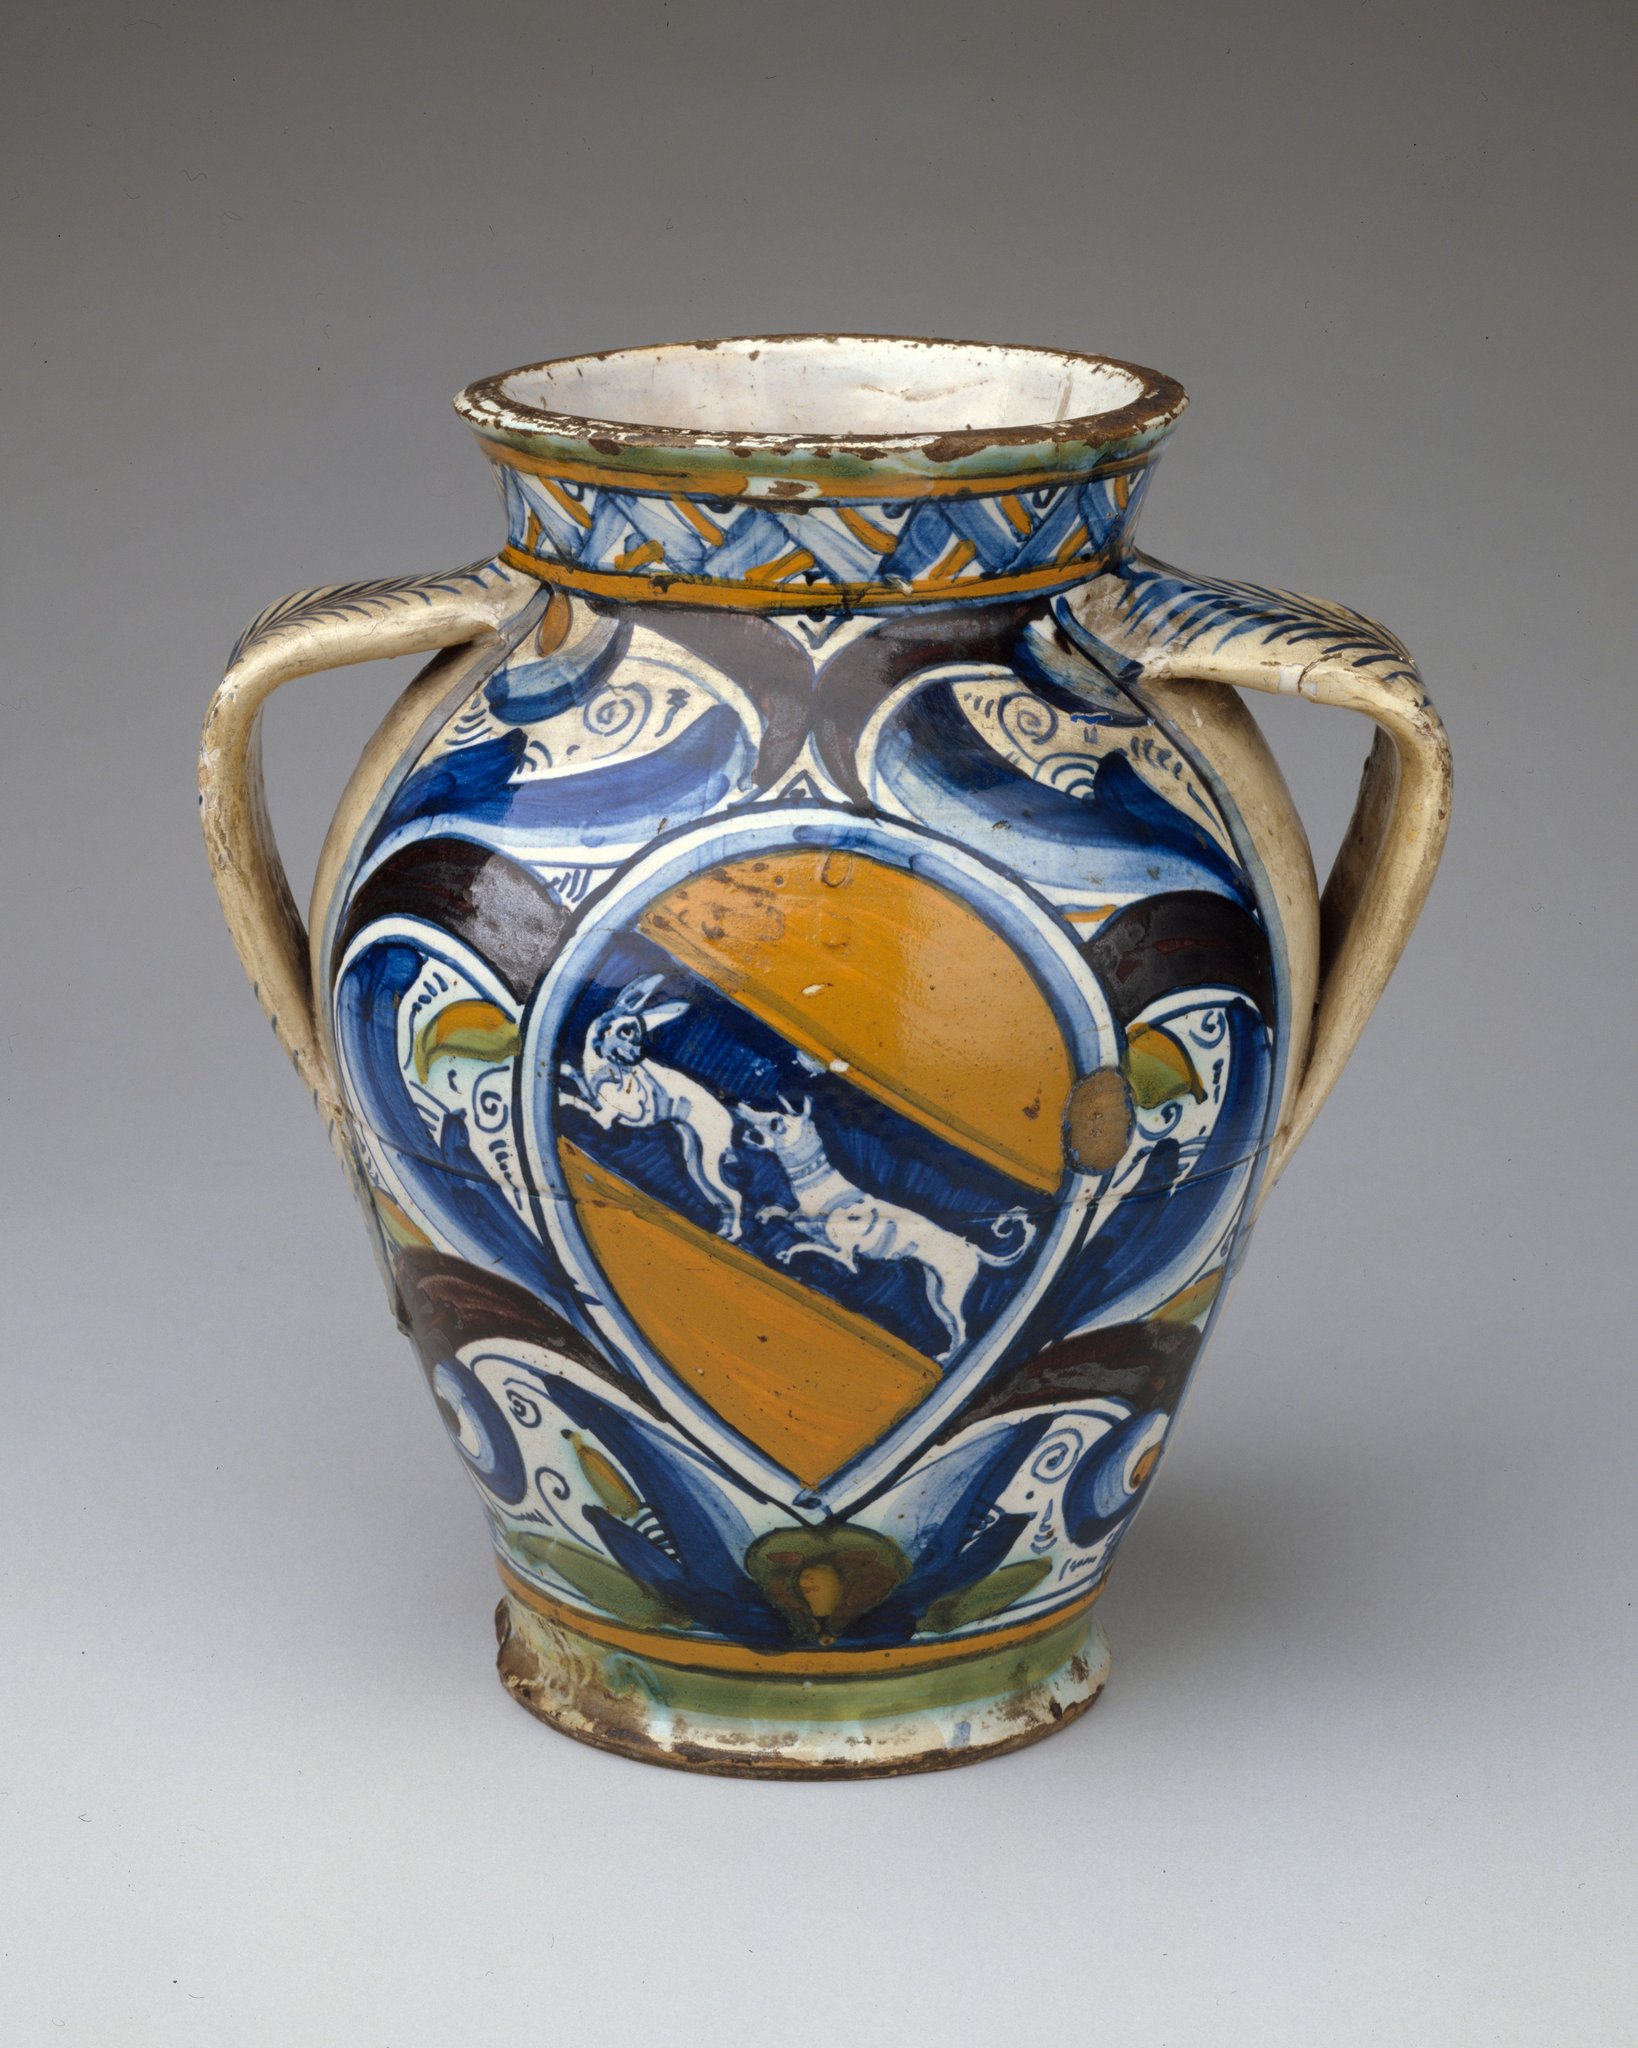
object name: apothecary jar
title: Apothecary Jar (orciuolo)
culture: italian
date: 1480-1520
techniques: maiolica, glazing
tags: dogs,rabbits